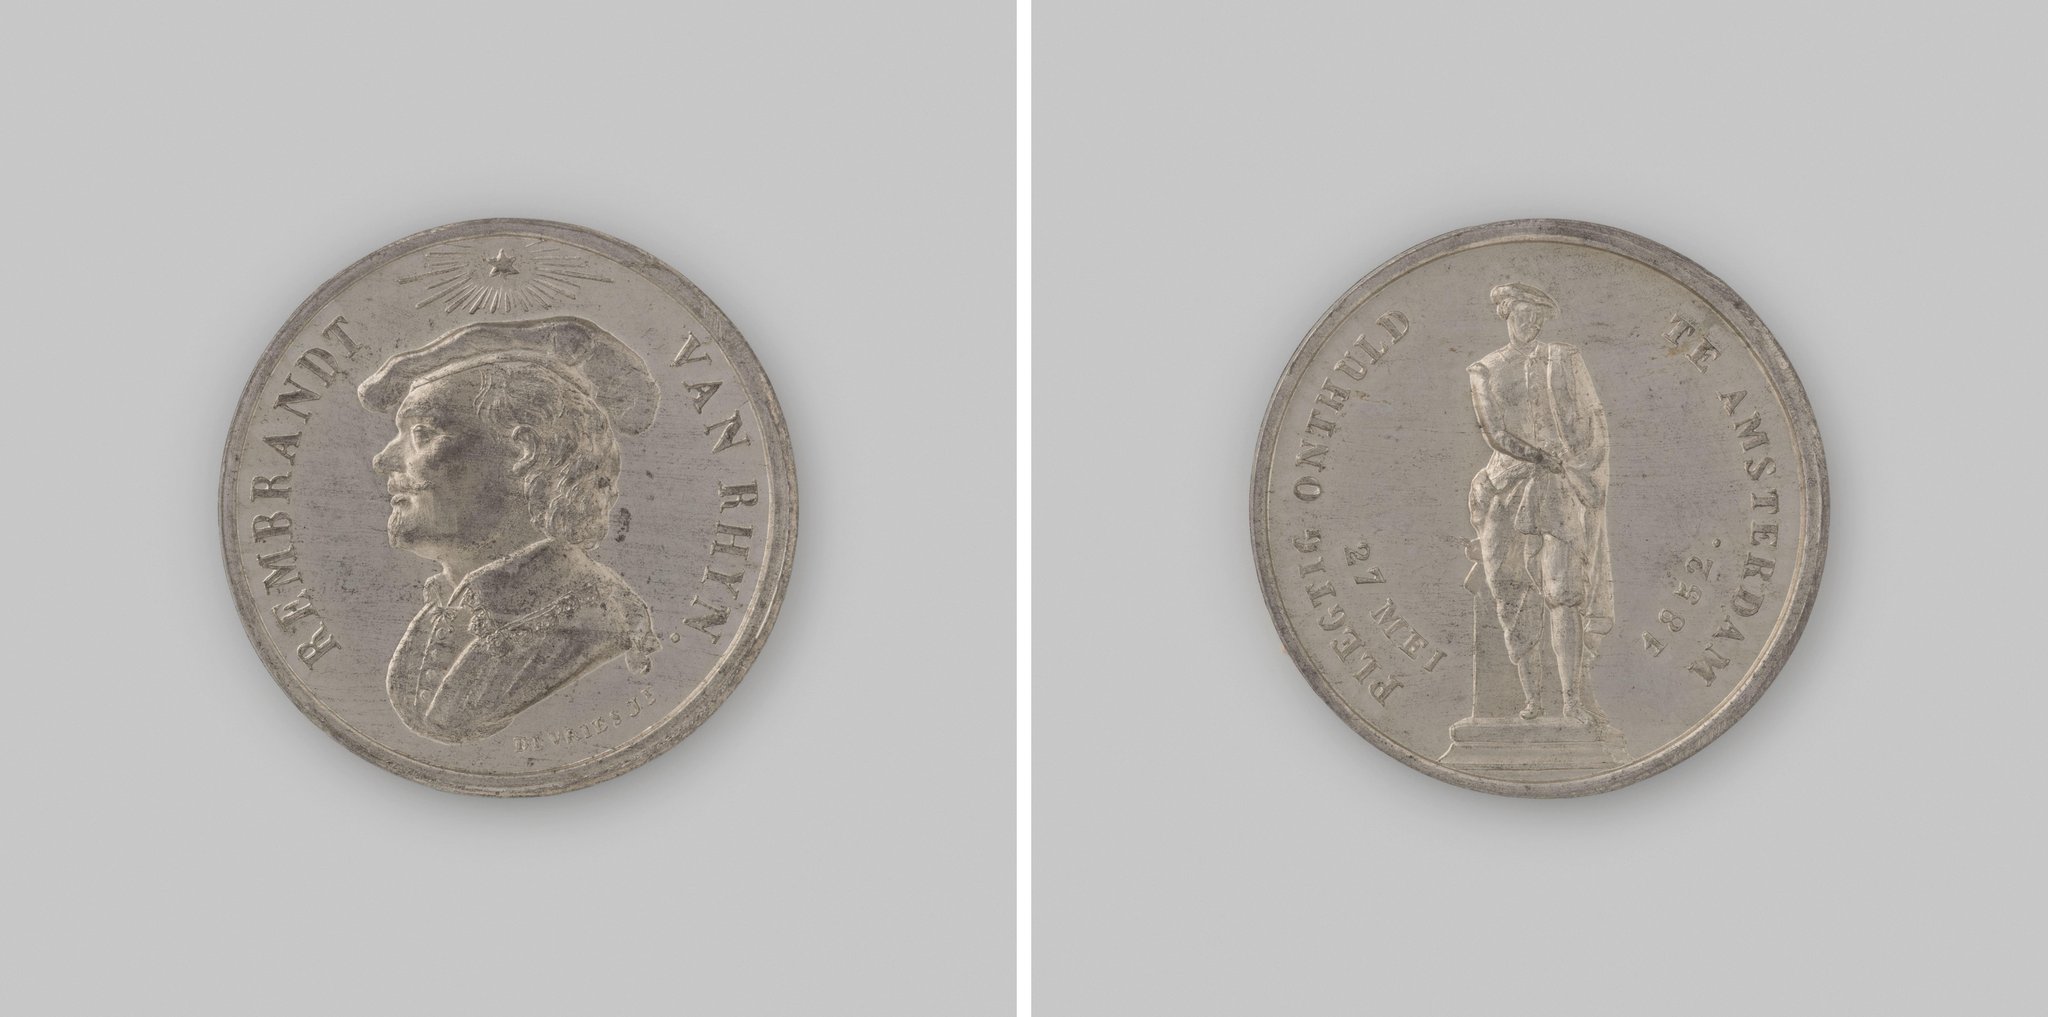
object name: history medal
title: Onthulling van het standbeeld van Rembrandt van Rijn te Amsterdam 1852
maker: moses cohen de vries junior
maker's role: diamantslijper, graveur, medailleur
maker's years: 1807-1883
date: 1852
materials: tin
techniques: striking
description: Tinnen penning, op de voorzijde het borstbeeld van Rembrandt naar links onder een stralende ster, met omschrift, op de keerzijde het onthulde standbeeld tussen 27 MEI en 1852, met omschrift.